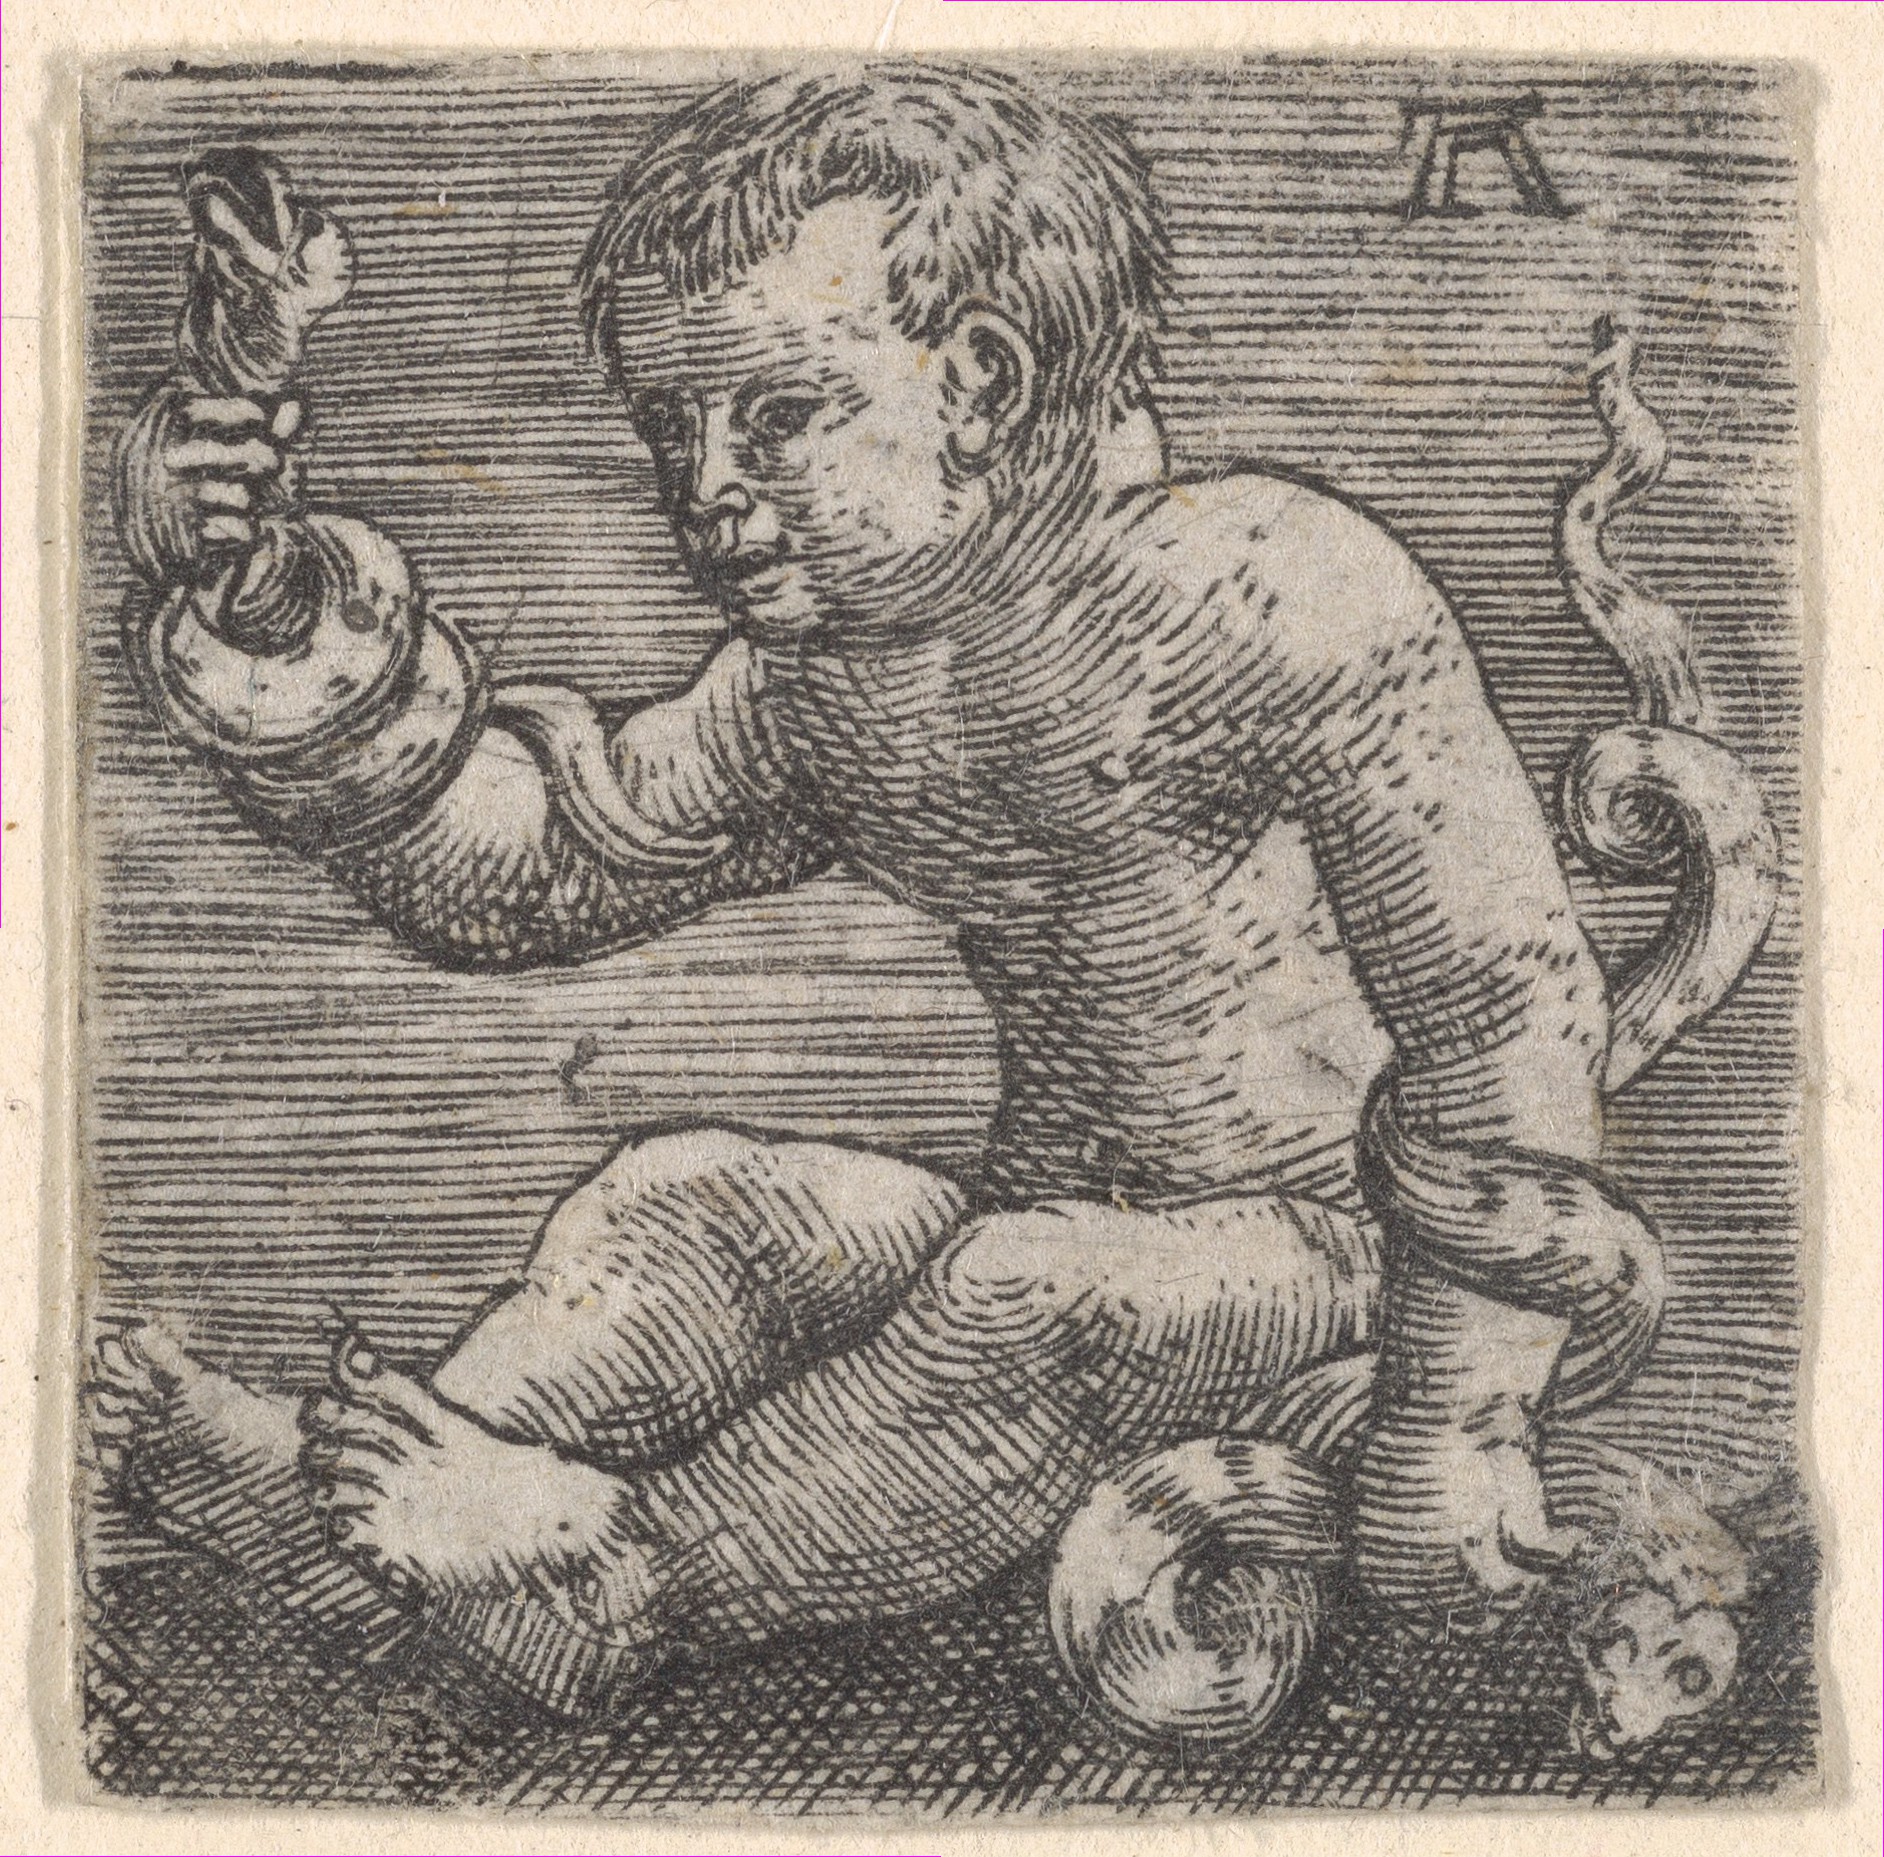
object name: print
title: Young Hercules Killing the Snakes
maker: albrecht altdorfer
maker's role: artist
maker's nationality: german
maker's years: 1480-1538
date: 1500-1538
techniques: engraving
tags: hercules,snakes